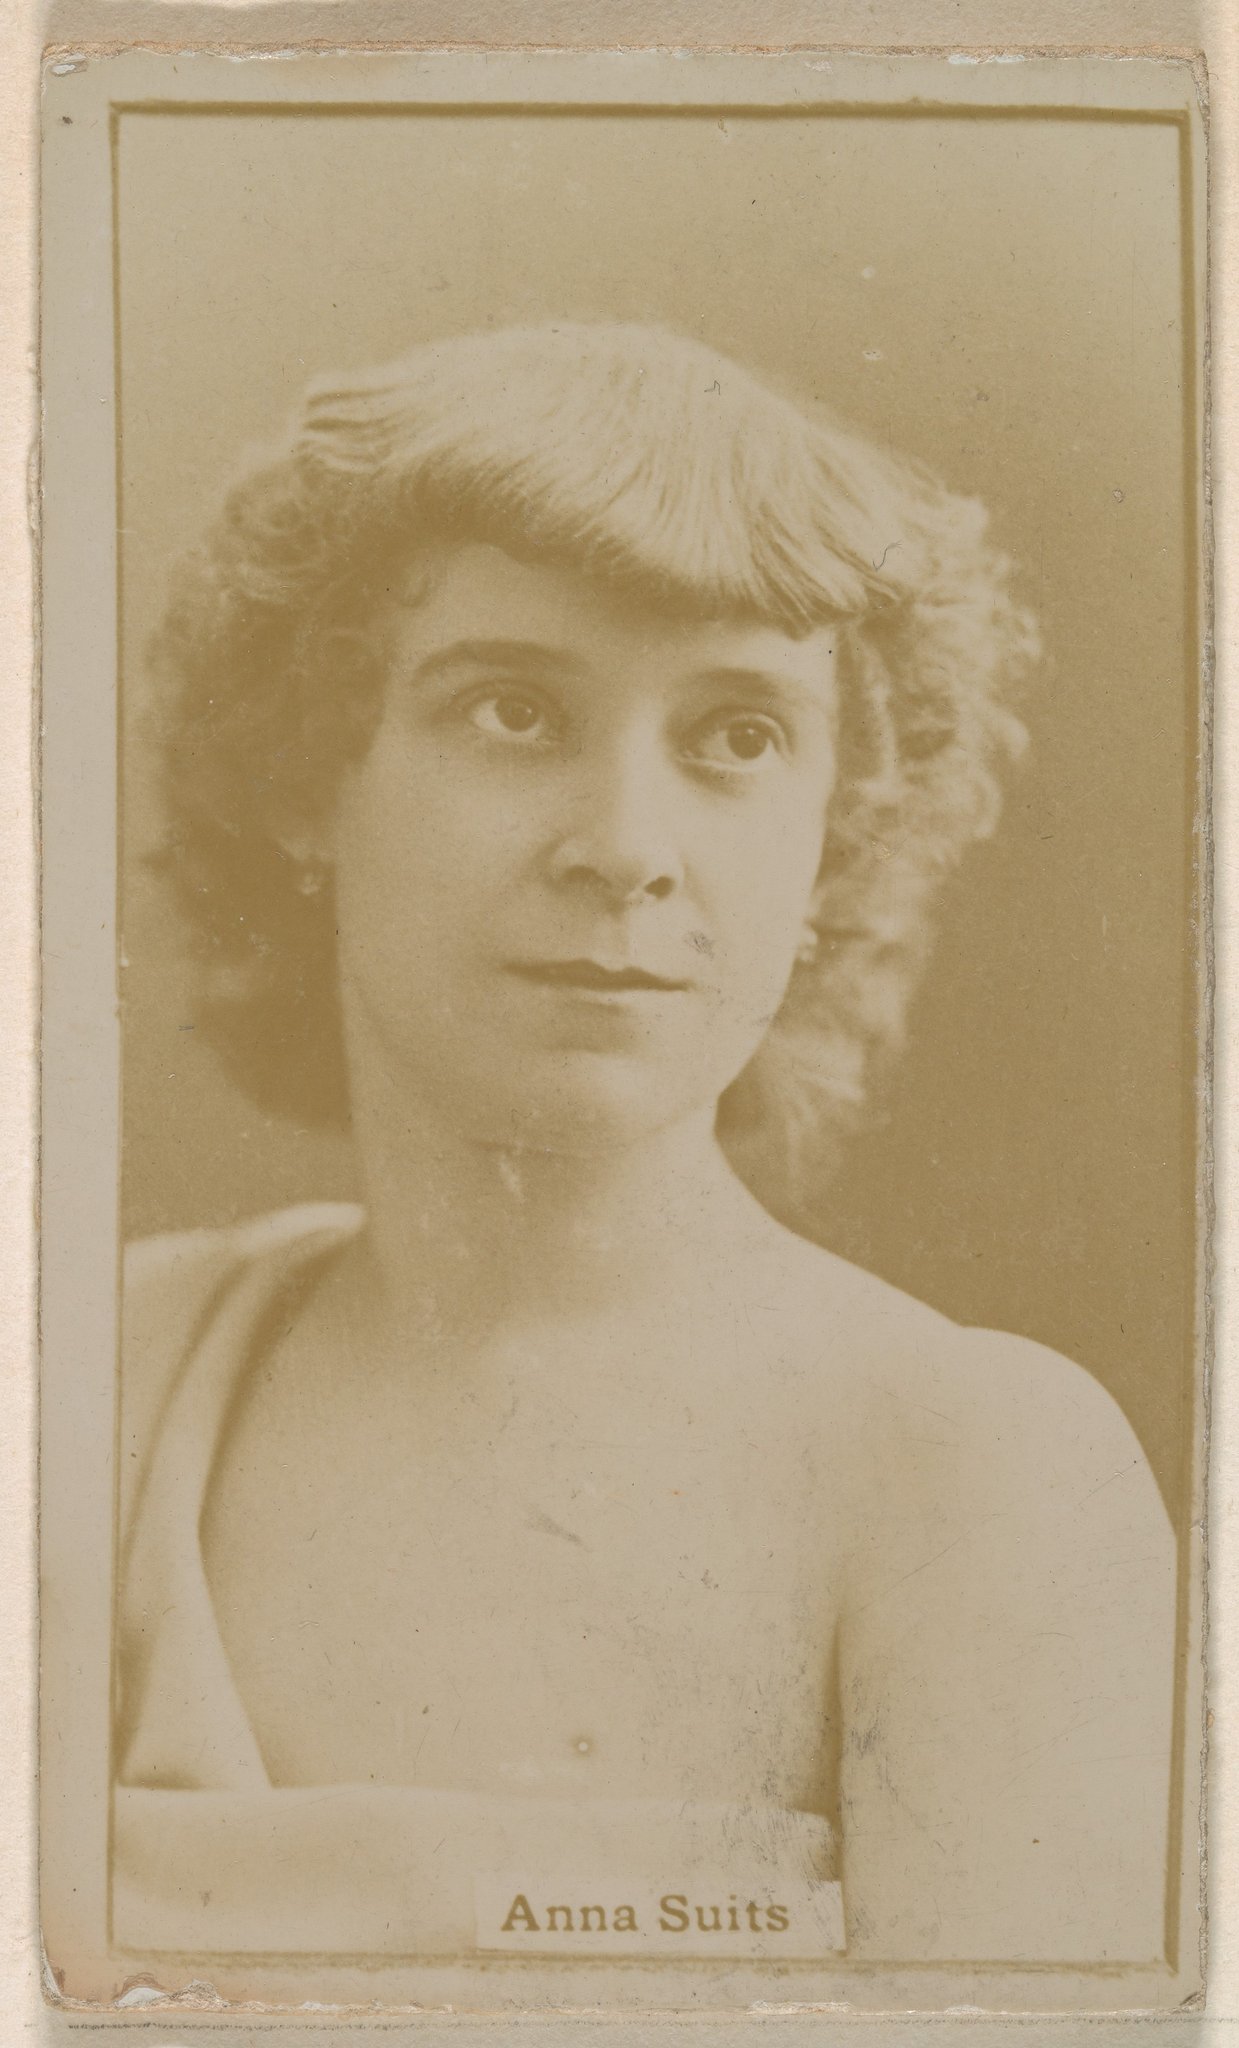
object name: photograph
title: Anna Suits, from the Actresses series (N245) issued by Kinney Brothers to promote Sweet Caporal Cigarettes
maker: kinney brothers tobacco company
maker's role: publisher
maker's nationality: american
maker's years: 1869-2011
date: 1890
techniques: albumen silver print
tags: portraits,women,actresses